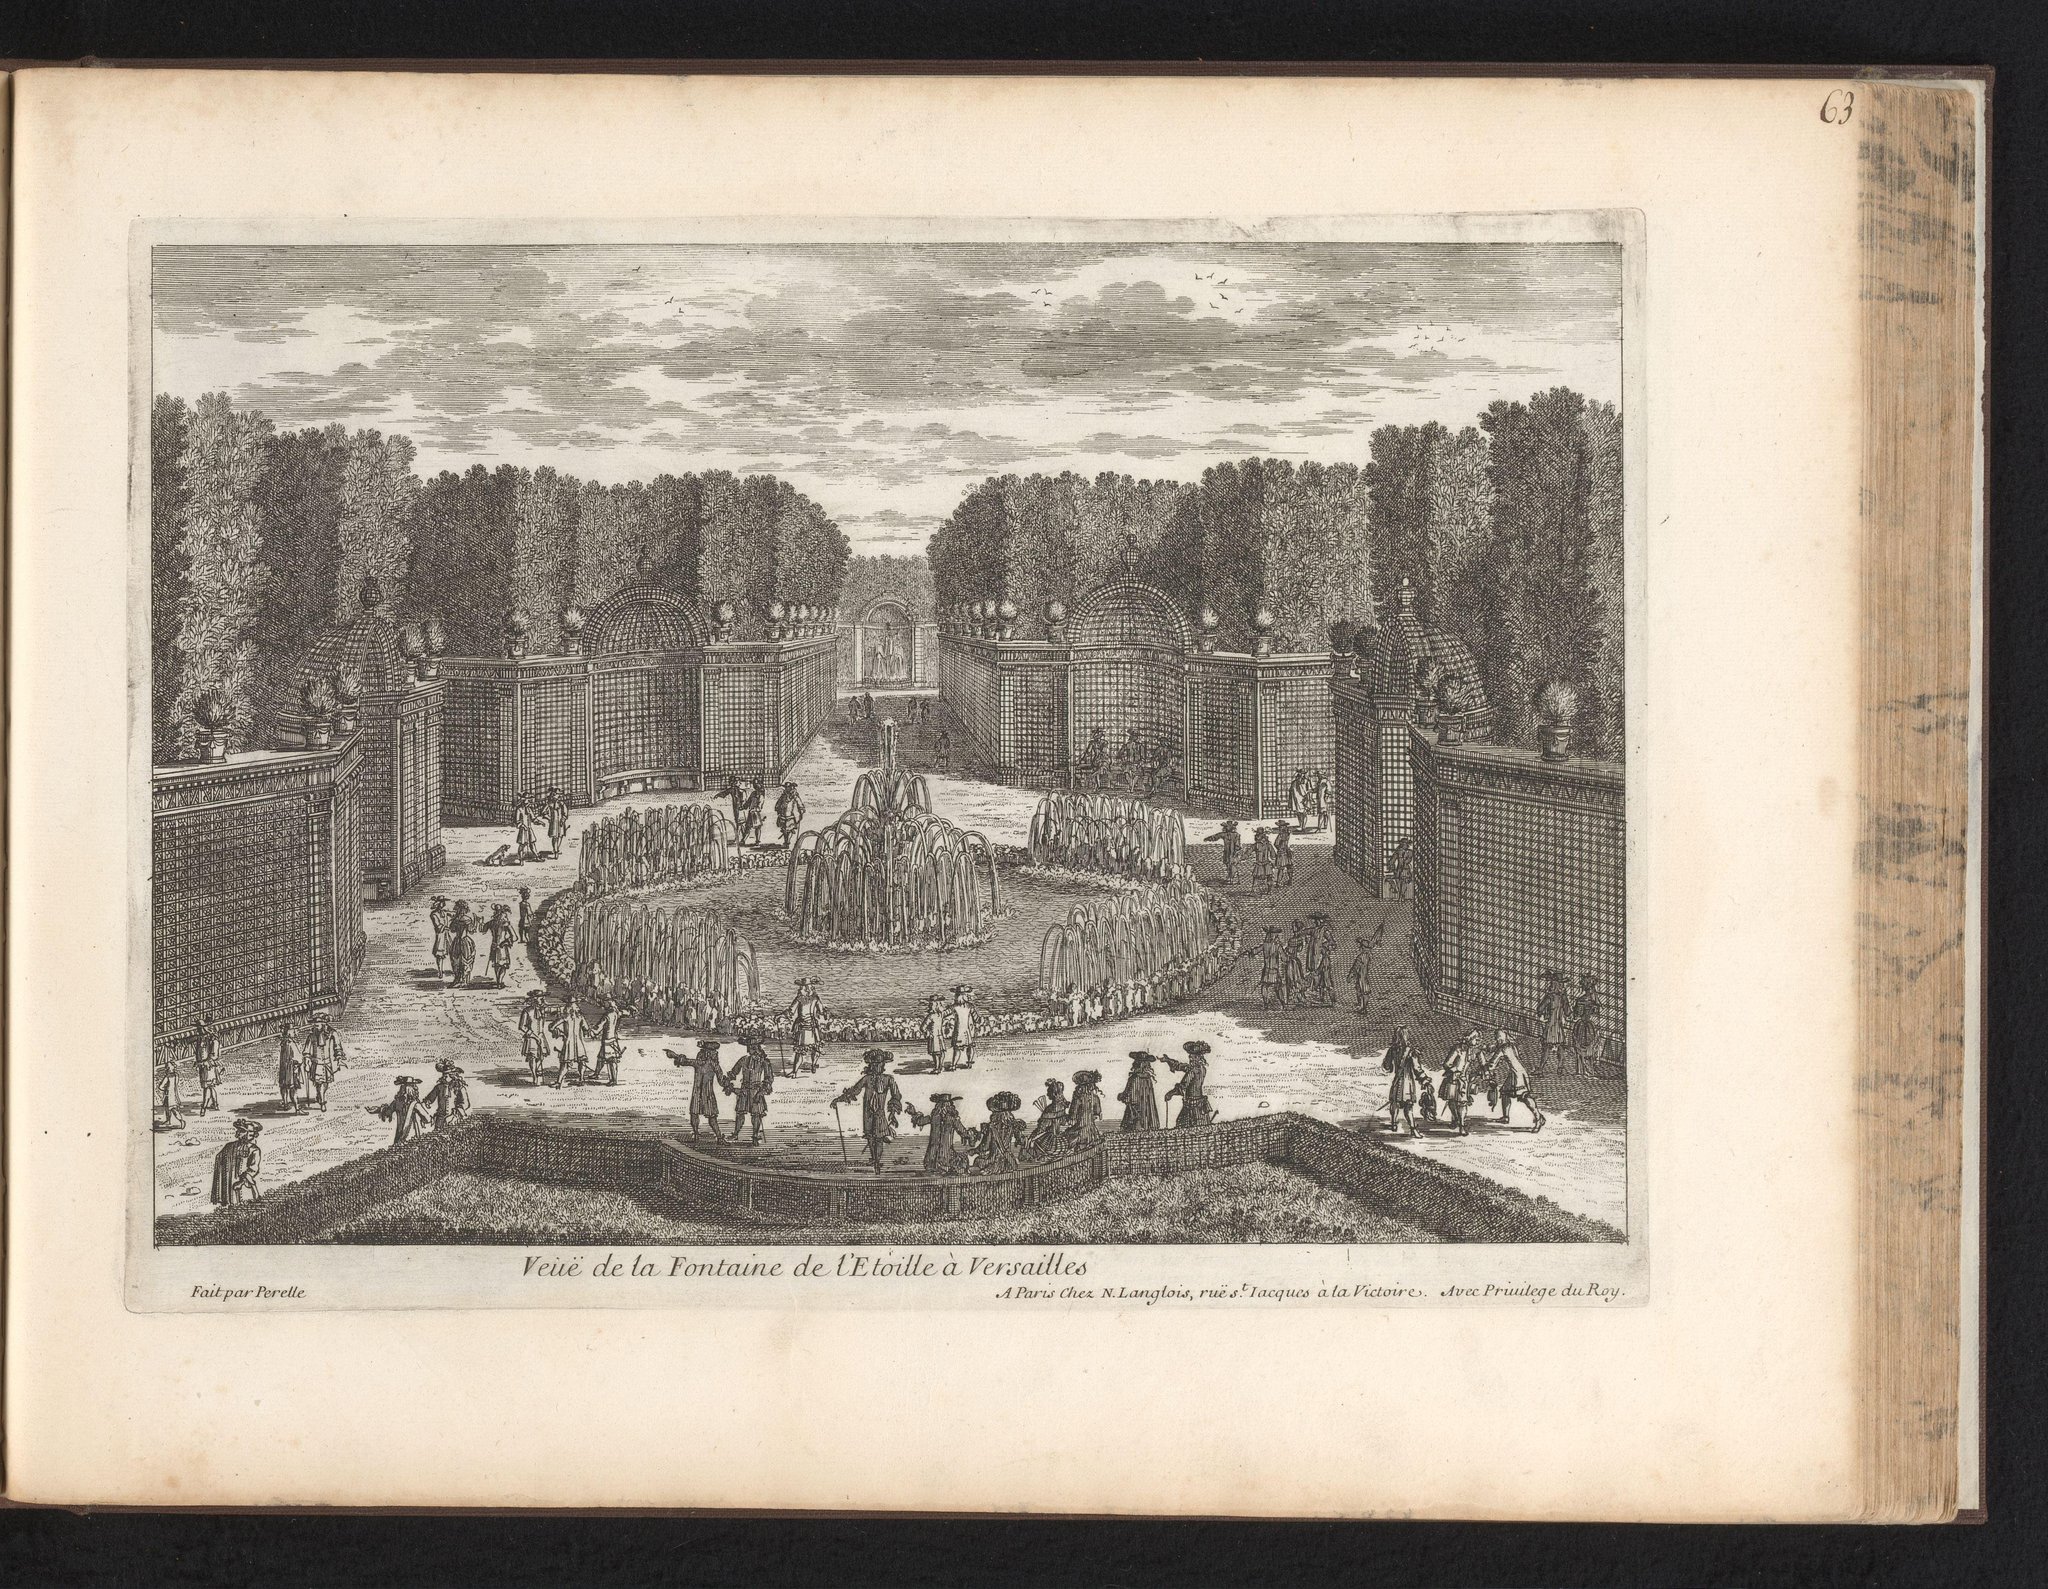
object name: album leaf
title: Veuë de la Fontaine de l'Etoille à Versailles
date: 1664-1703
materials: paper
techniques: etching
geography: paris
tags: garden fountain, french or architectonic garden; formal garden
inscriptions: collector's mark: Lugt 2228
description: Prenten met het signatuur 'Perelle' kunnen zowel door vader Gabriel als door zonen Nicolas en Adam gemaakt zijn. De uitgevers vader en zoon Nicolas Langlois worden allebei vermeld als N. Langlois op hetzelfde adres.